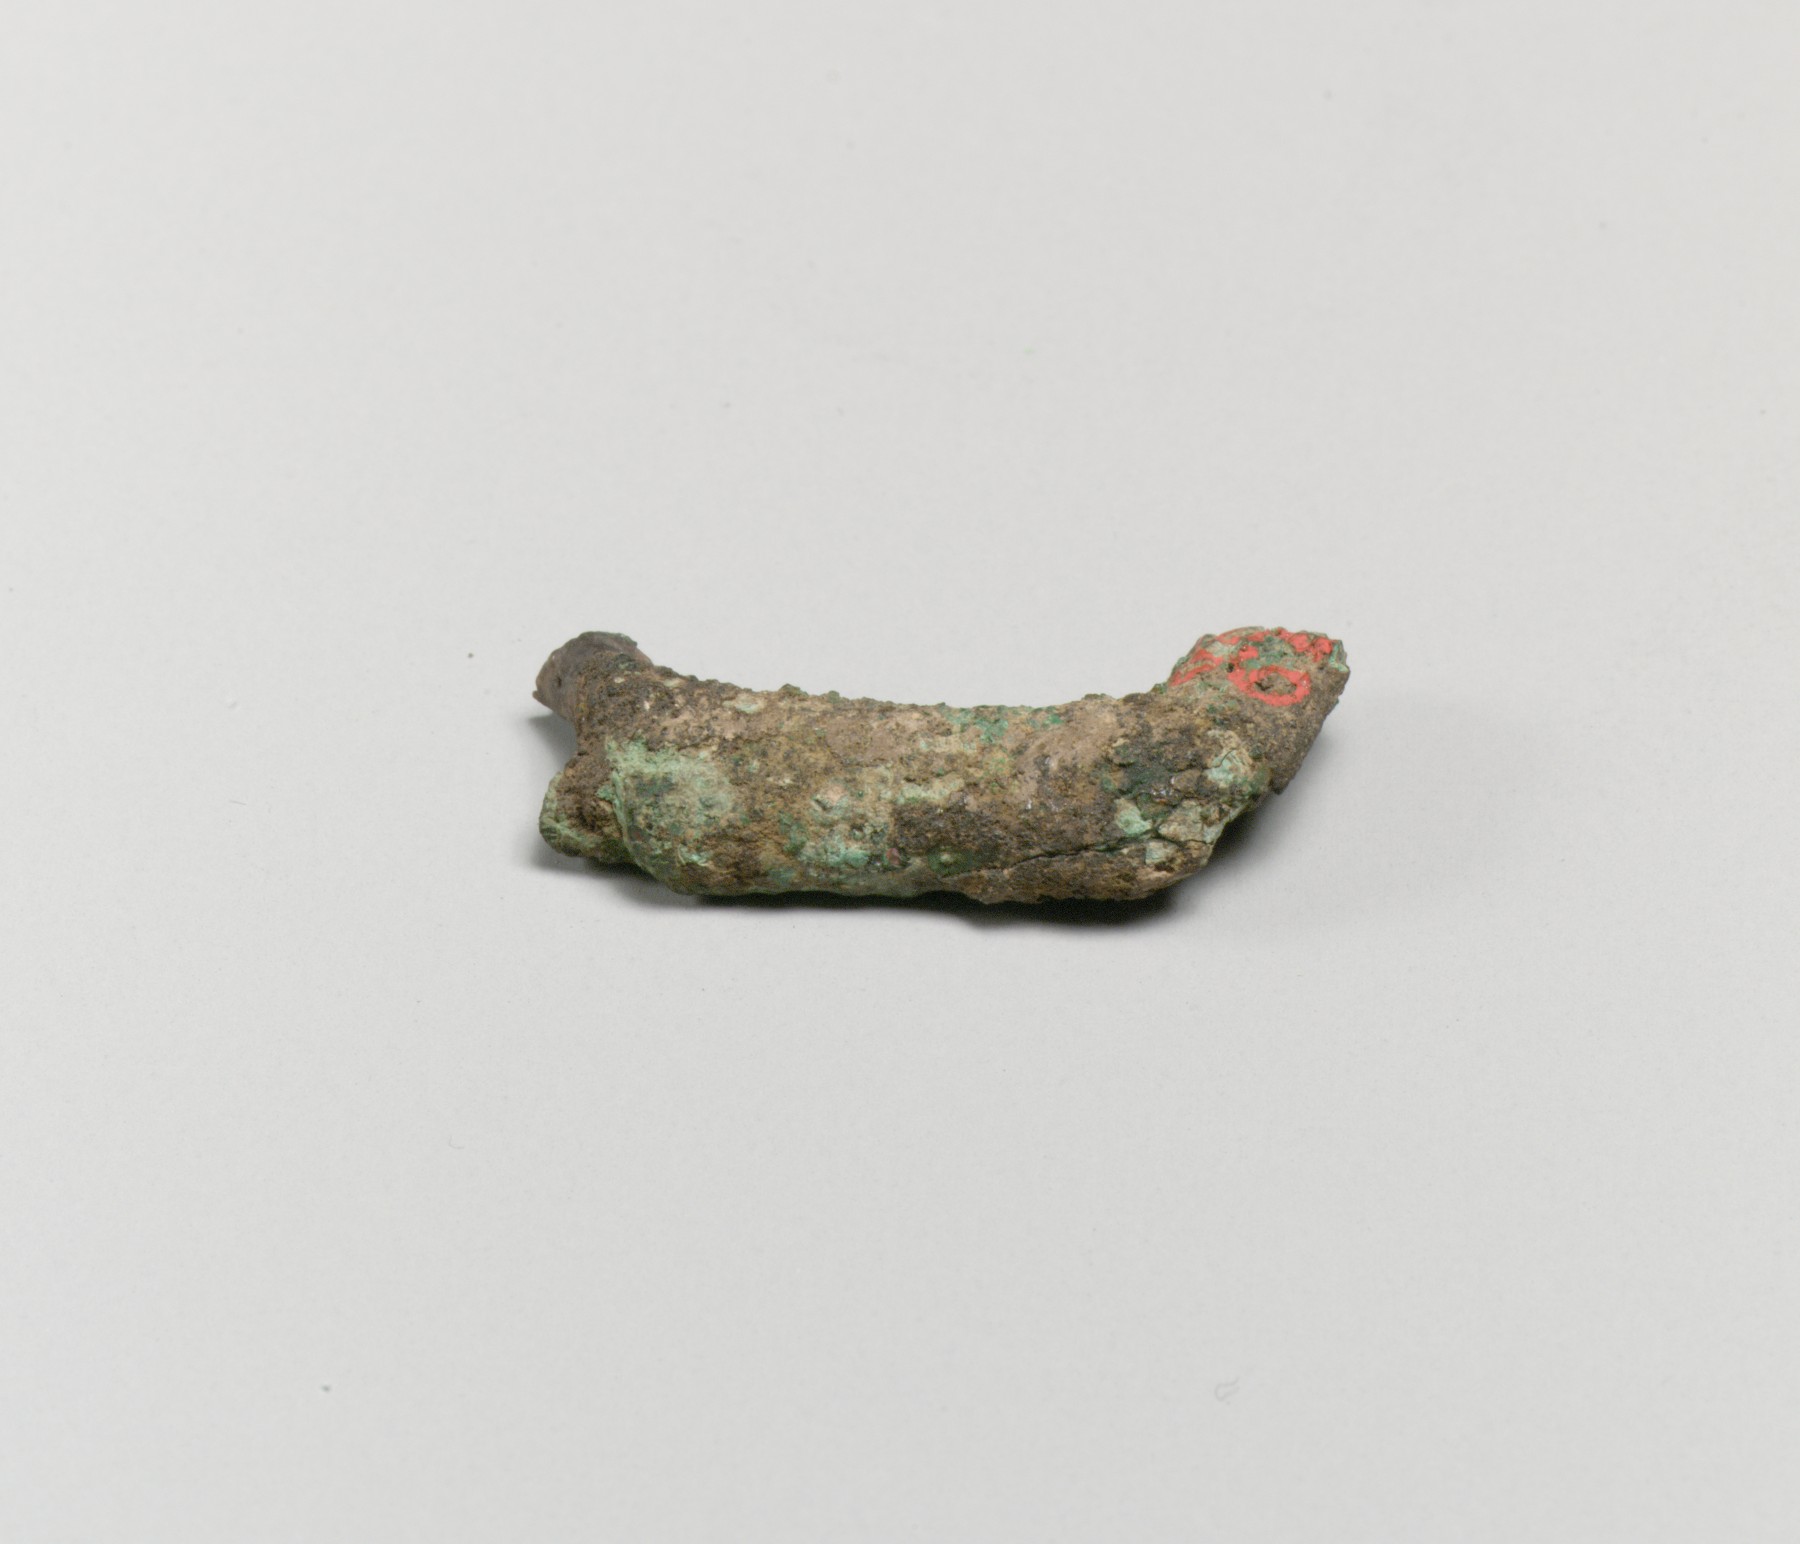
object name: fibula, certosa type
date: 600-401 BCE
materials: bronze